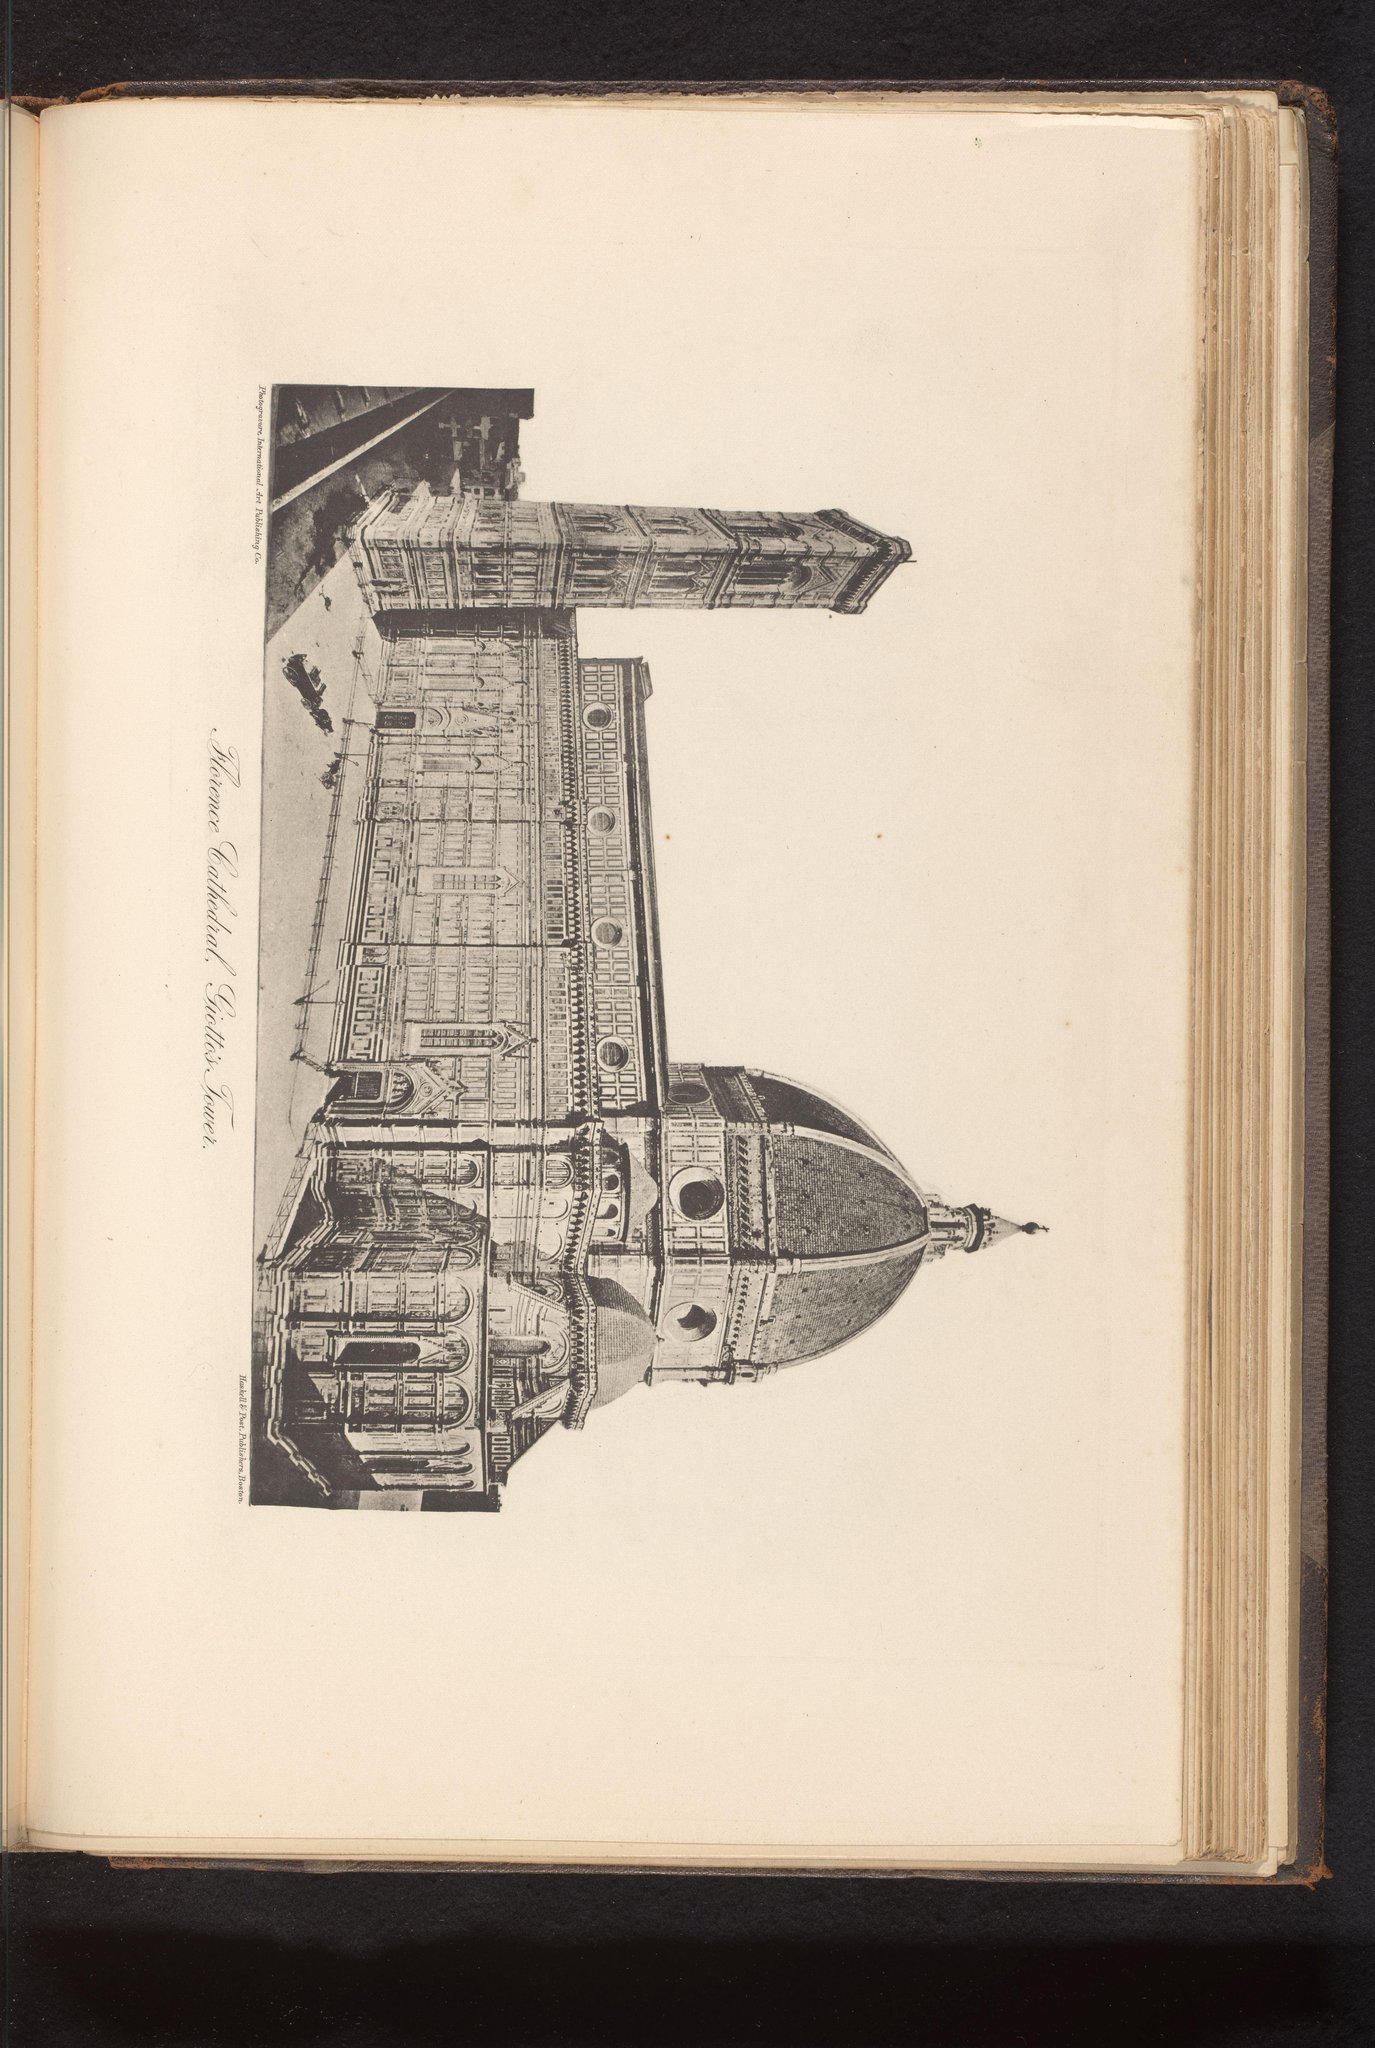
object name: photomechanical print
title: Florence Cathedral, Giotto's Tower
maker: Anonymous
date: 1881-1886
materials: paper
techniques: photograph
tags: church (exterior)